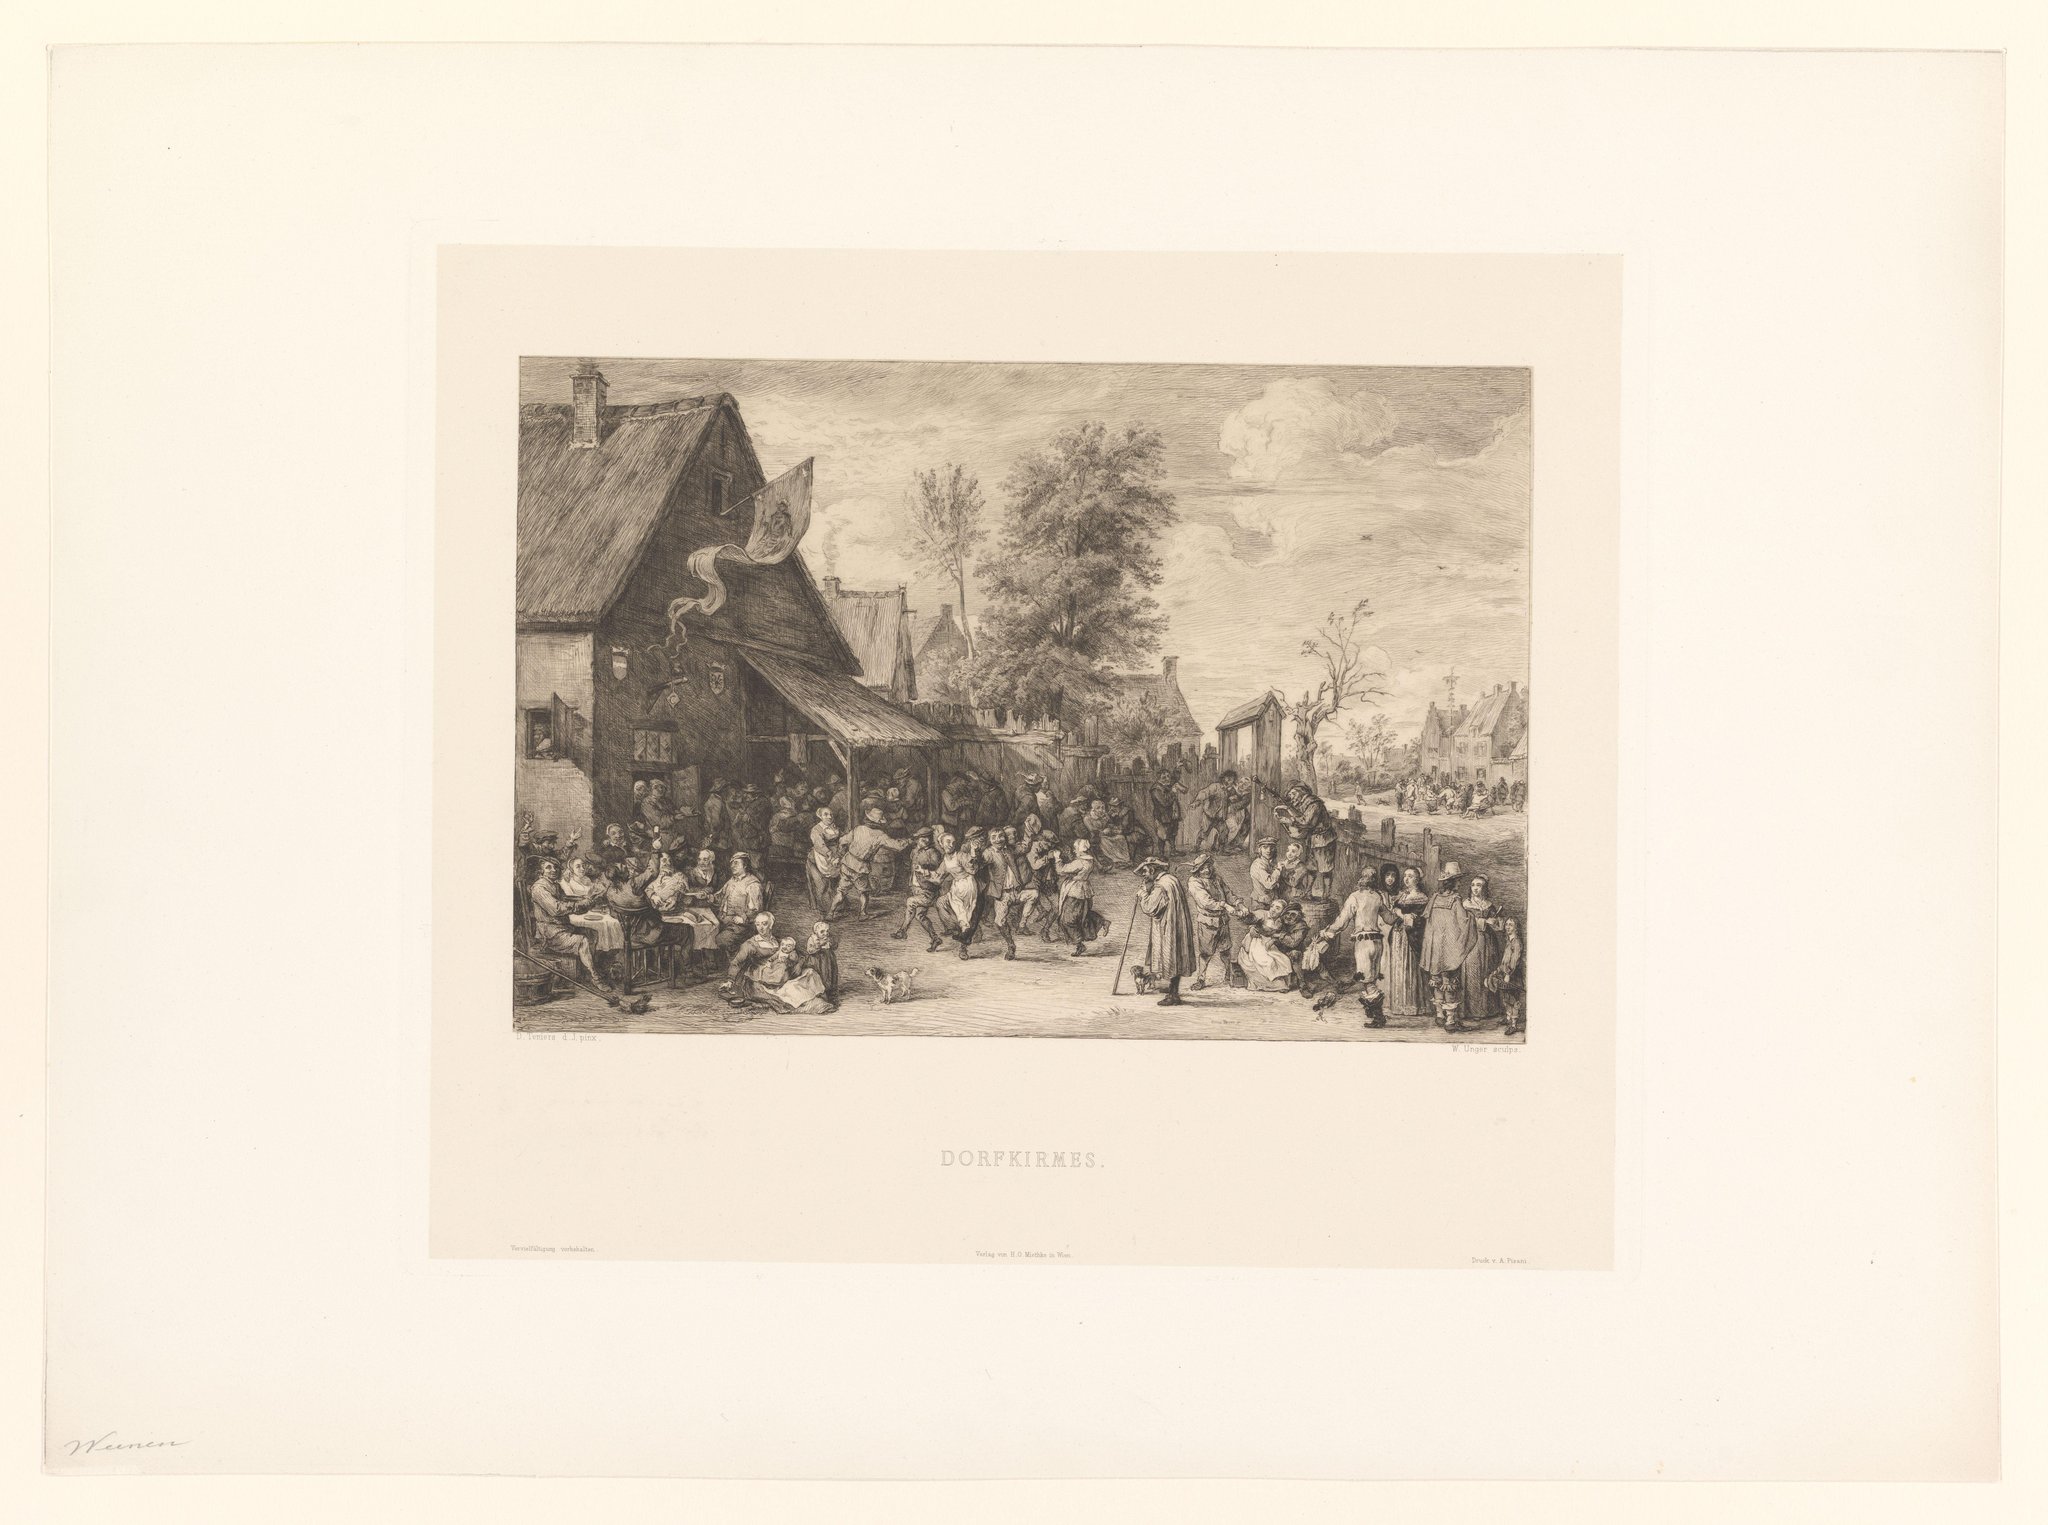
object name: print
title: Dorfkirmes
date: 1861-1889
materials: paper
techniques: etching, intaglio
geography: vienna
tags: folk dancing (men and women together), pleasure fair and circus, hotel, hostelry, inn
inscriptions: collector's mark: Lugt 2228